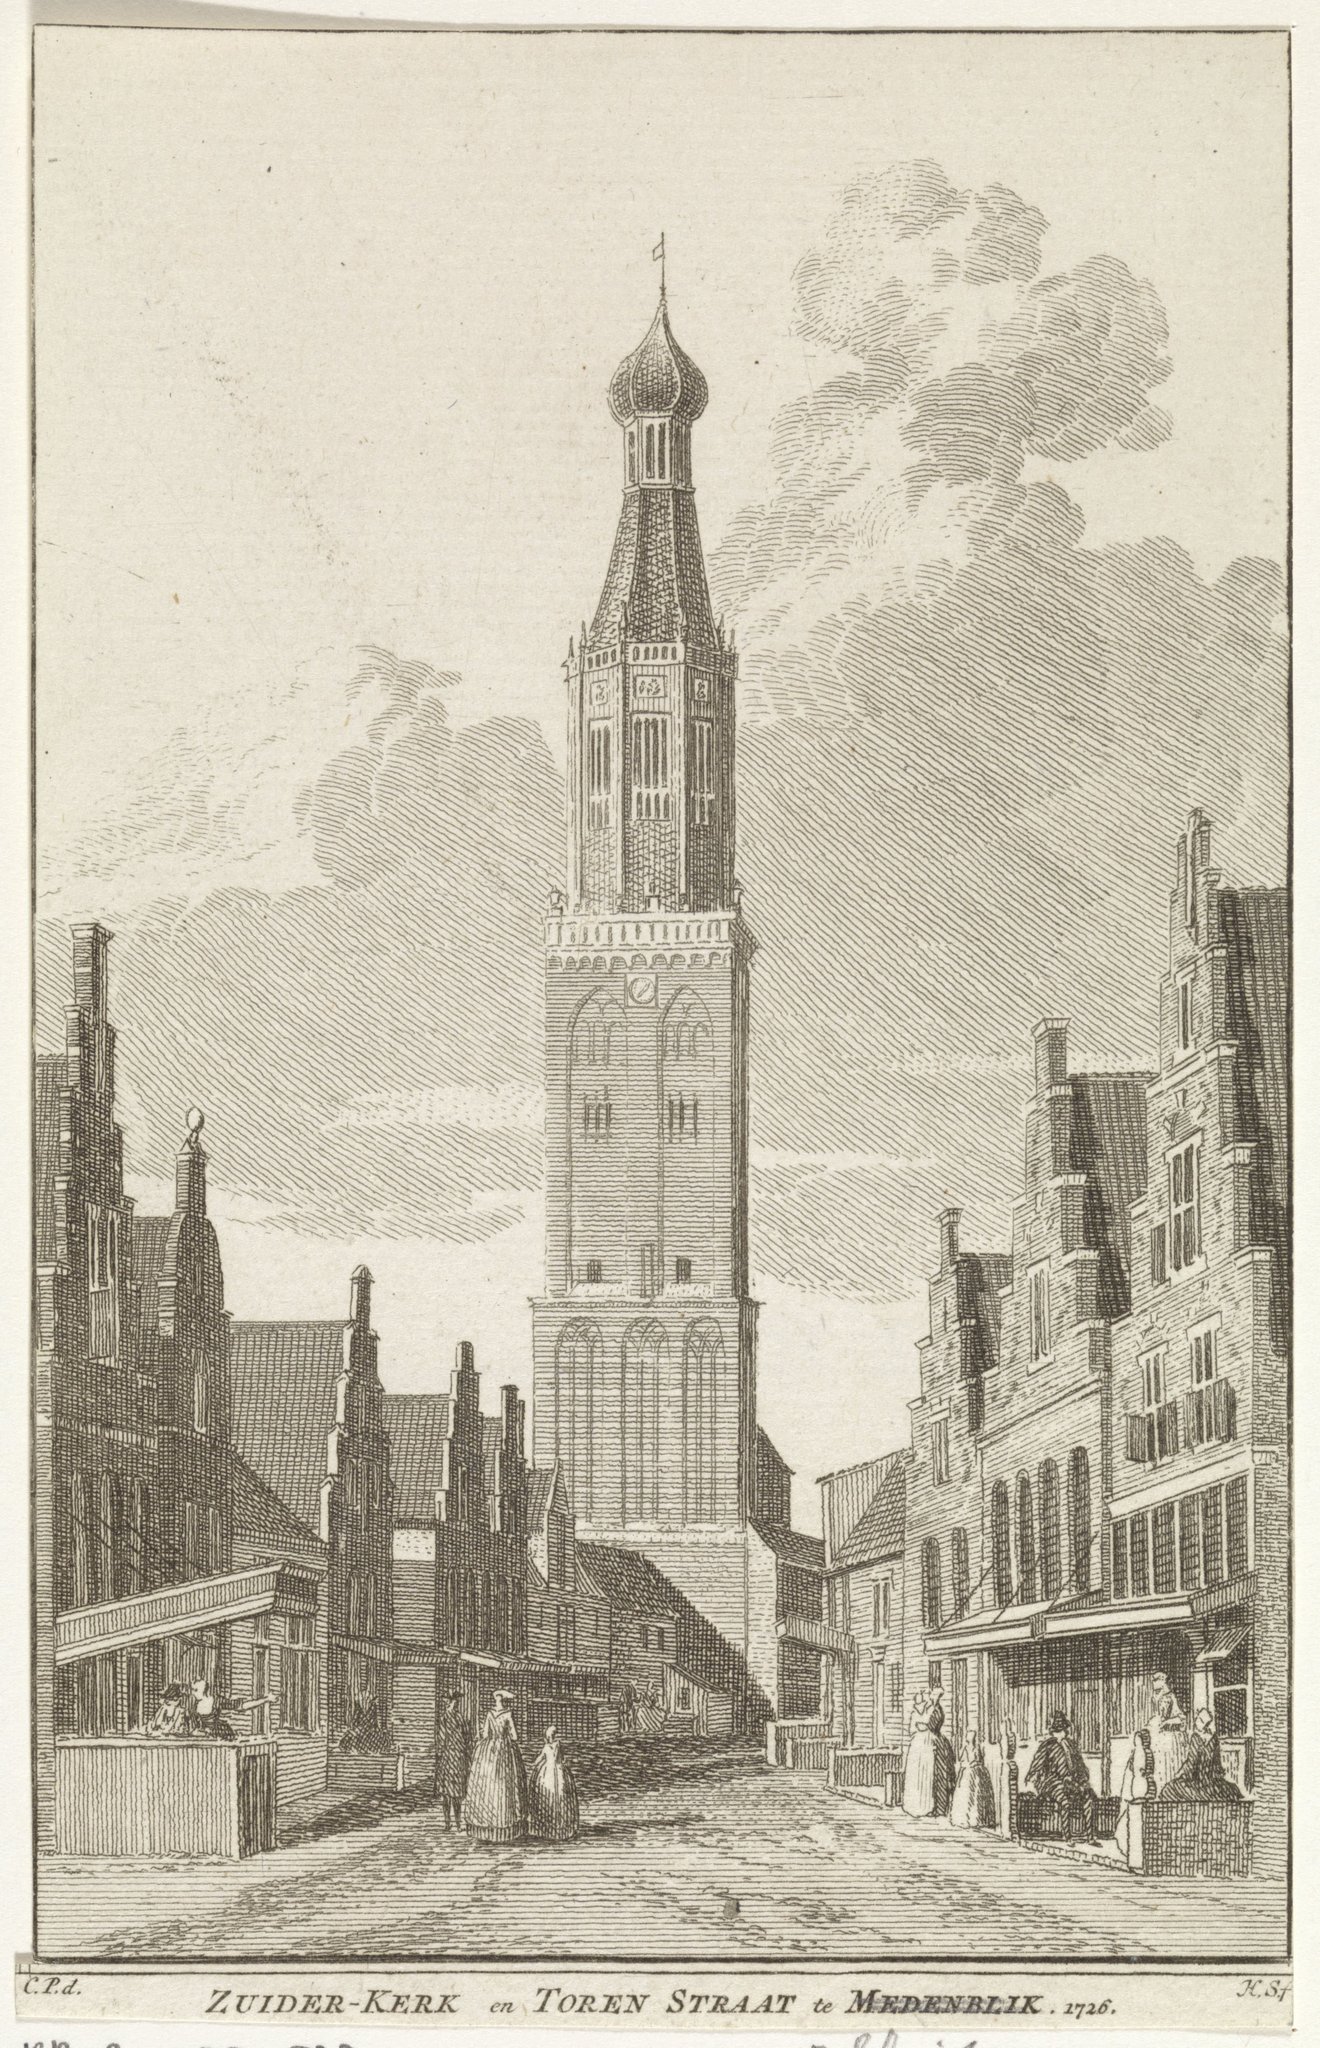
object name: book illustration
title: Zuider-Kerk en Toren Straat te Medemblick, 1726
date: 1752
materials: paper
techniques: etching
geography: haarlem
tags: church (exterior), public road in village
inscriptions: collector's mark: Lugt 2228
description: Prent gebruikt in: Het verheerlykt Nederland of kabinet van hedendaagsche gezigten van steden, dorpen, sloten ... en andere voornaame stad- en landgebouwen, in en omtrent alle de byzondere Vereenigde Nederlandsche Provinciën : gedurende de laatste jaaren door vermaarden kunsttekenaren na het leven getekent en ... in 't koper gebragt ... dienende tot opheldering der beschryvinge van den Tegenwoordigen Staat der Vereenigde Nederlanden. Deel IV, 1752. Amsterdam: Isaac Tirion, 1745-1774.